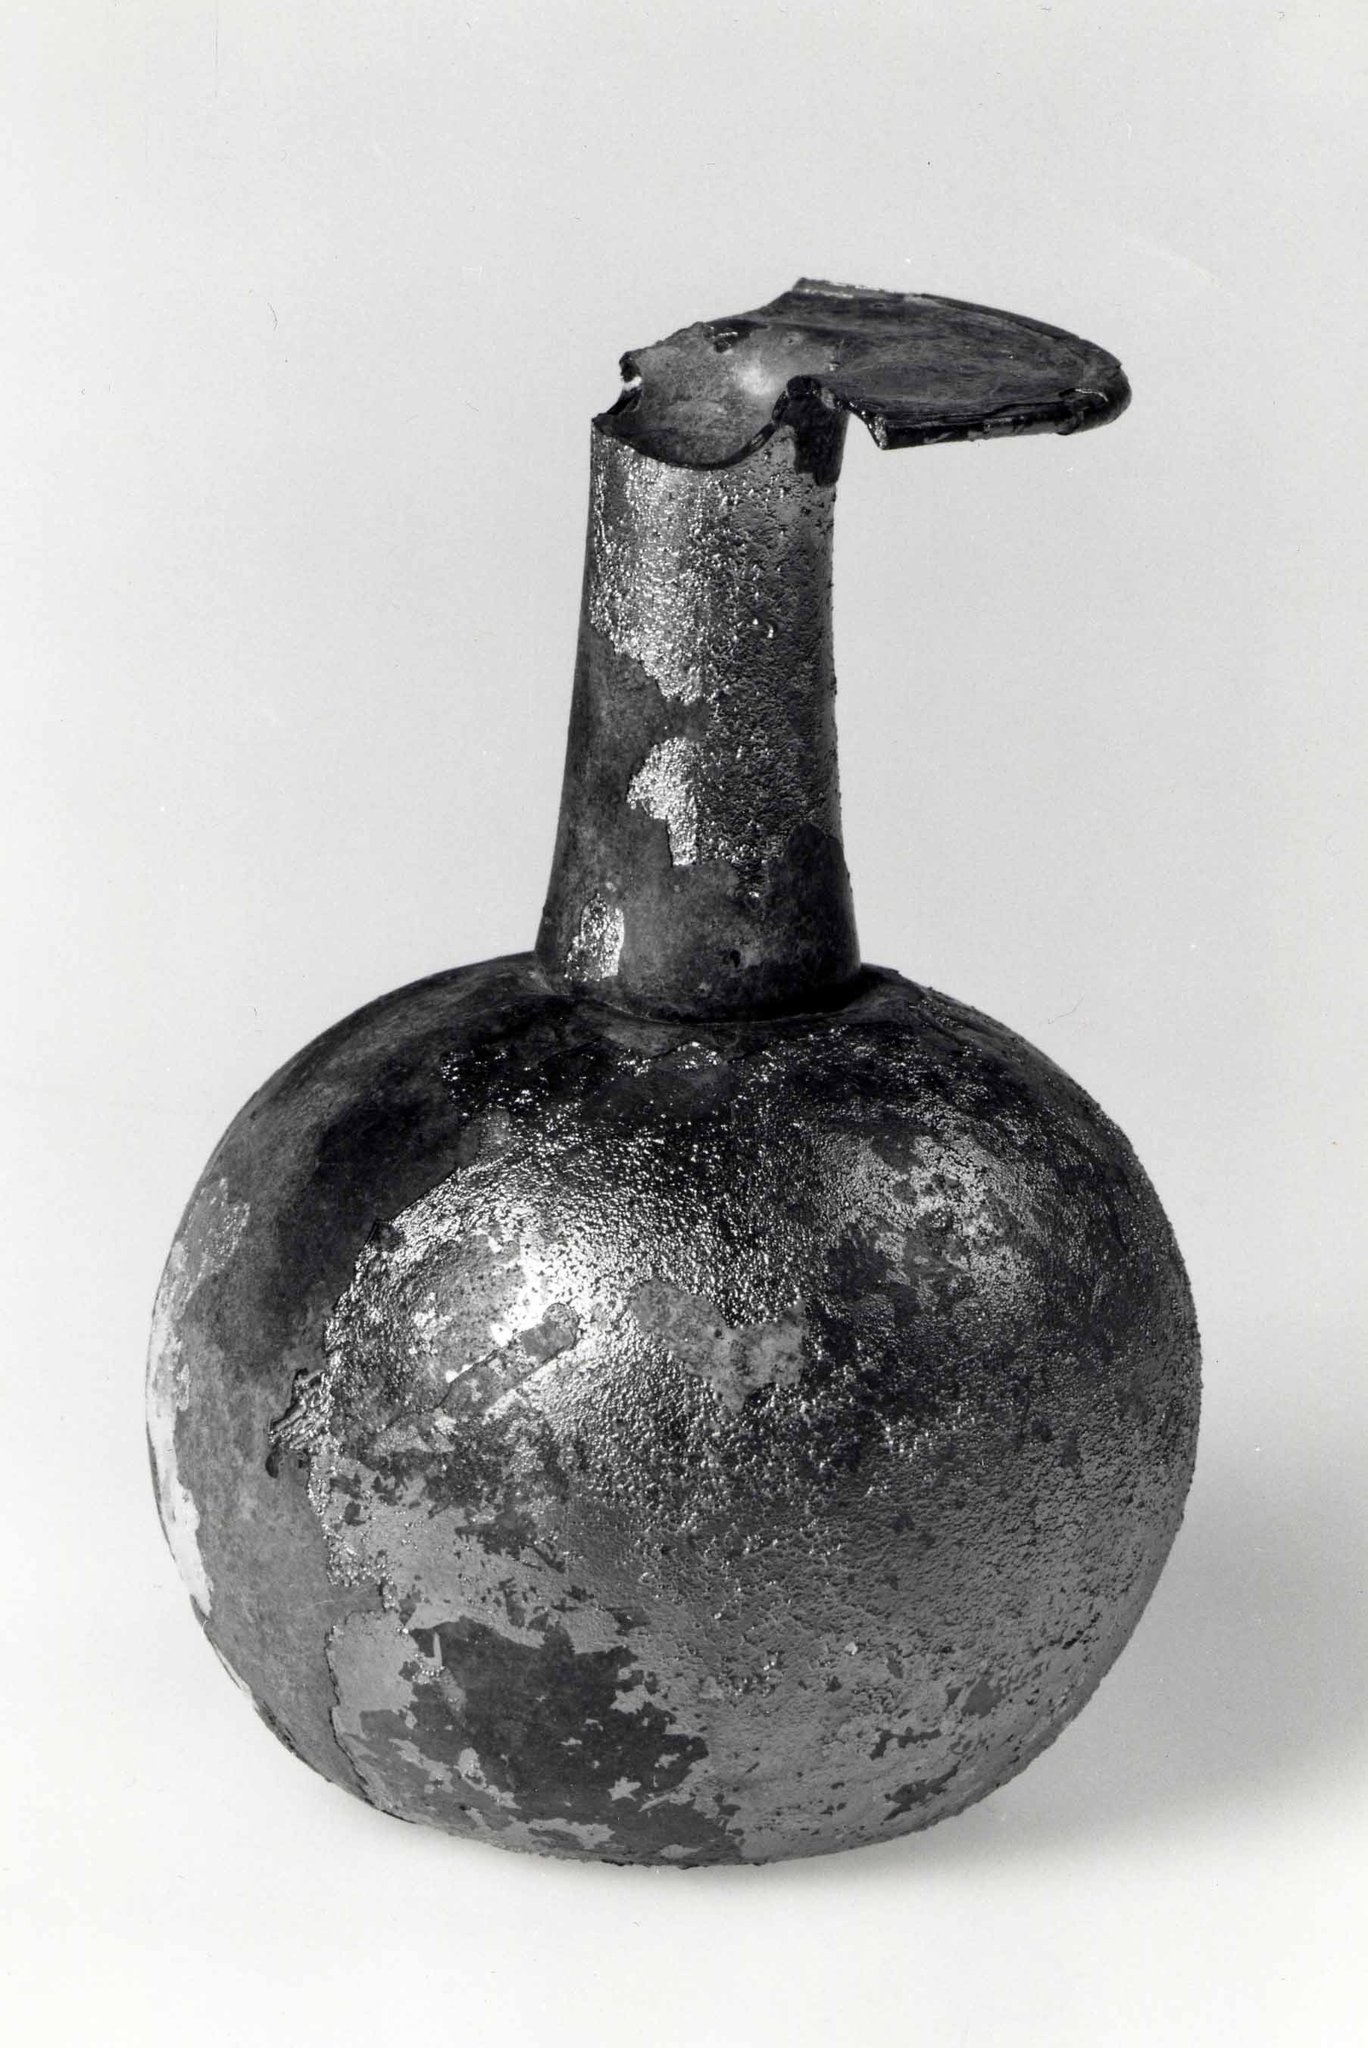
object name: dropper flask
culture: roman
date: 201-400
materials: glass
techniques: glassblowing, tooling